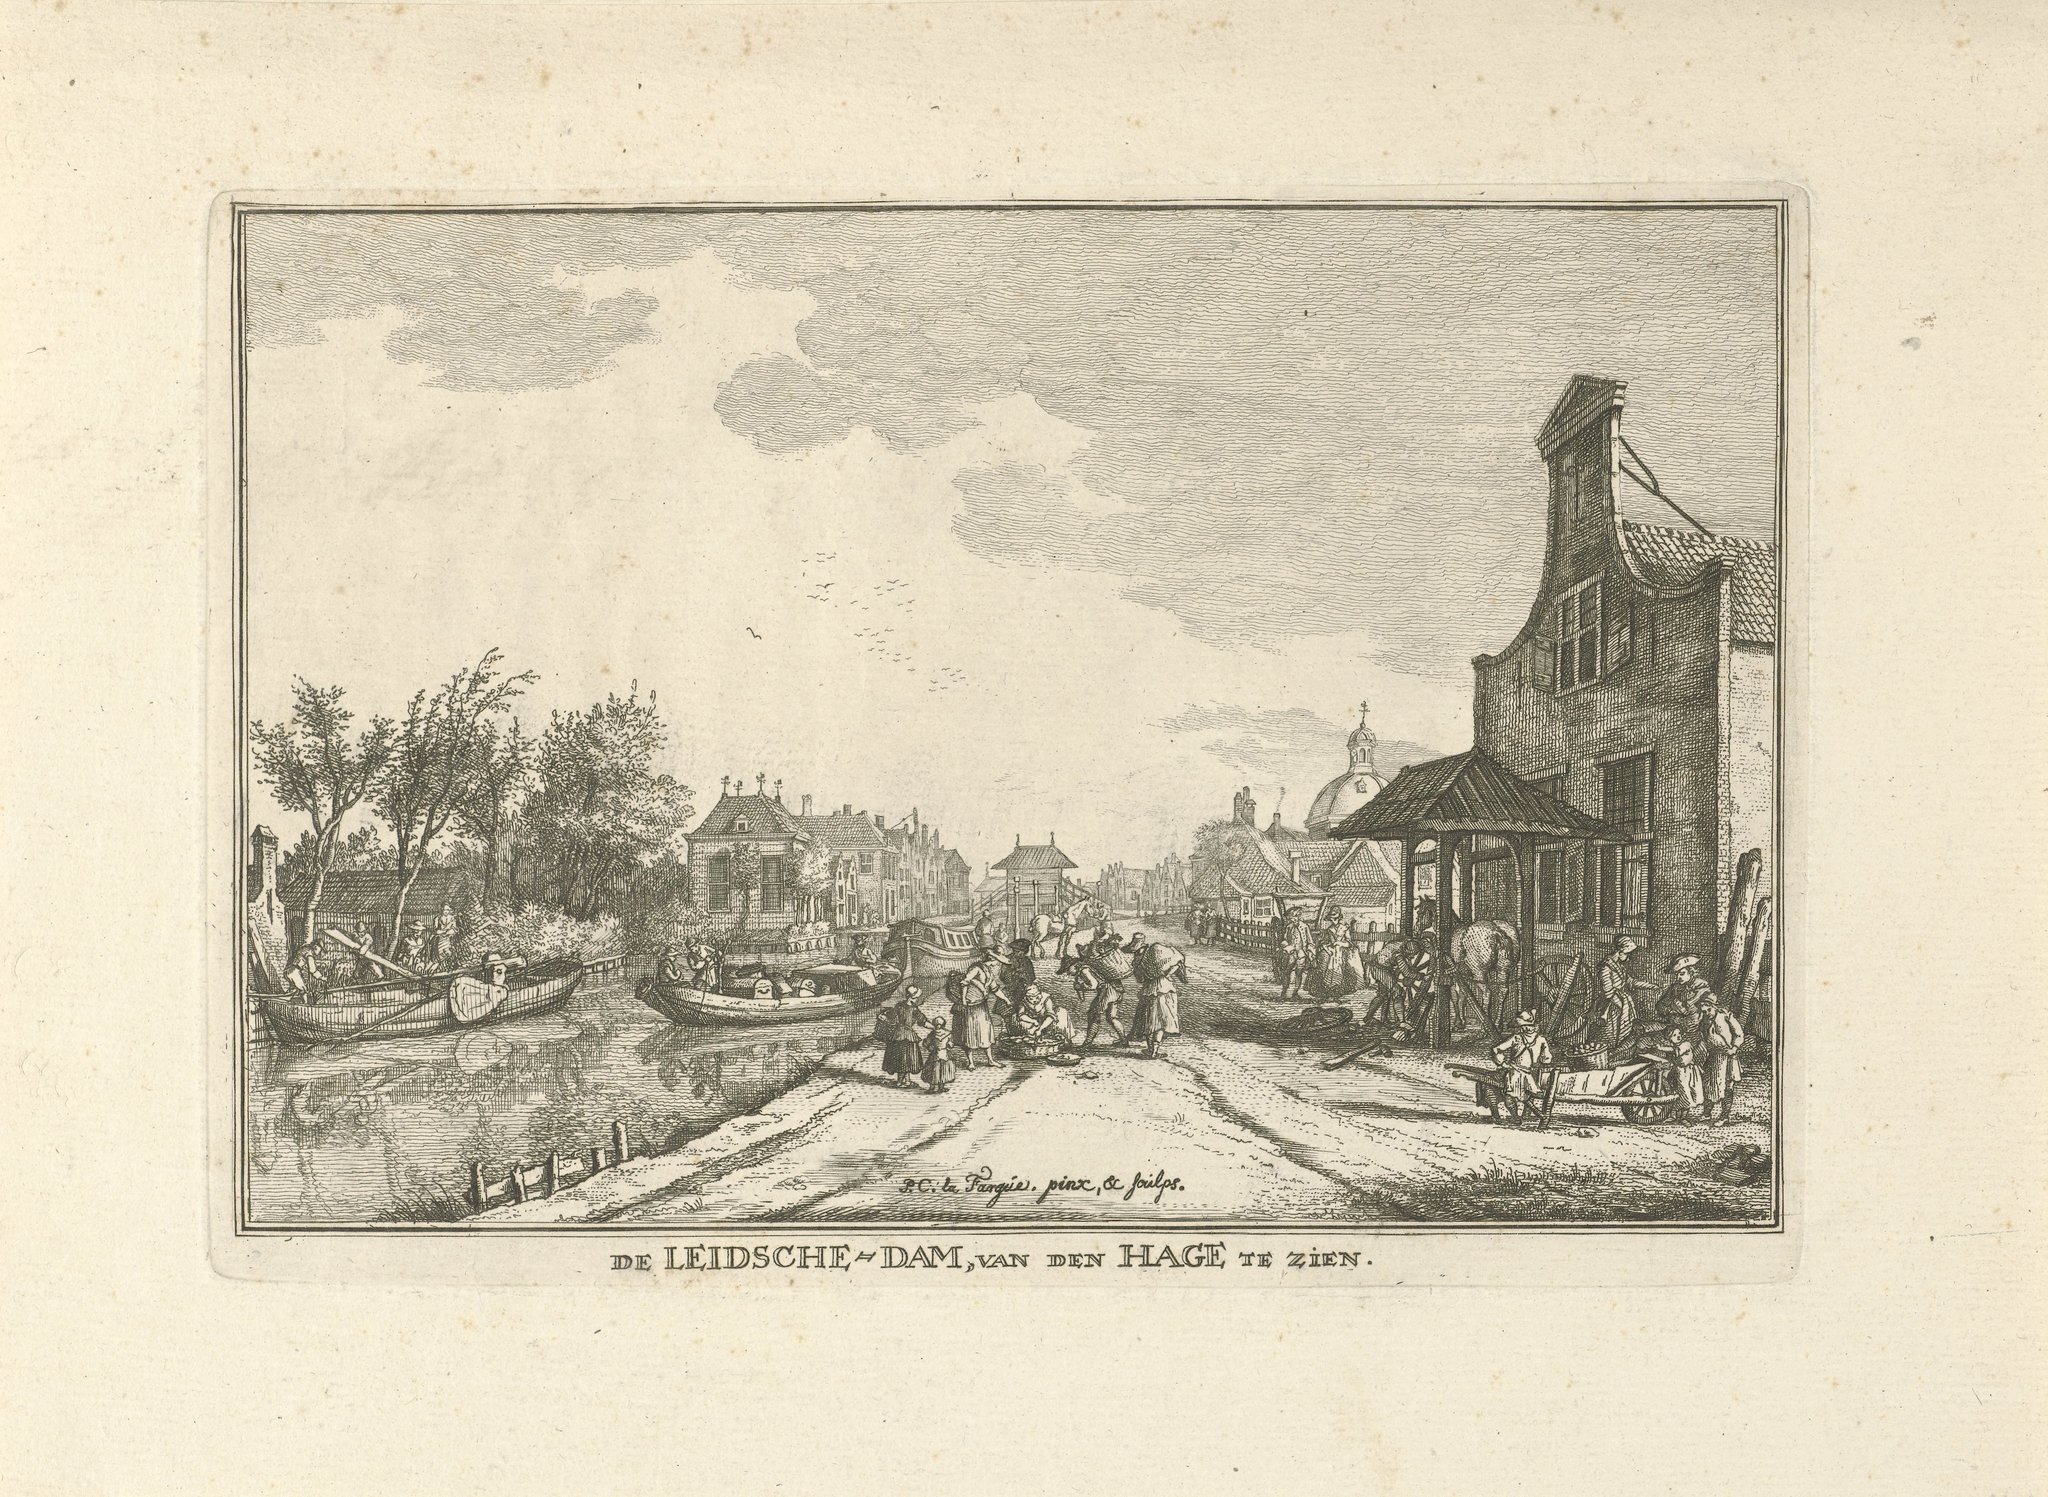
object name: print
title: De kom in de trekvaart tussen Leiden en Den Haag in Leidschendam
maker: paulus constantijn la fargue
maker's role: draughtsman, painter, print maker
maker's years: 1729-1782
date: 1739-1782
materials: paper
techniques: etching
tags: canals, waters (in village), ships (in general)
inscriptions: collector's mark: Lugt 2228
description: De kom in de trekvaart tussen Leiden en Den Haag in Leidschendam. Het verlaat en de kom gezien vanaf de Haagse zijde in de richting van Leiden. In de sluiskom liggen trekschuiten, rechts op de kade lopen wandelaars en boeren. In de verte de koepel van de Hervormde Kerk aan de Delftse Kade.